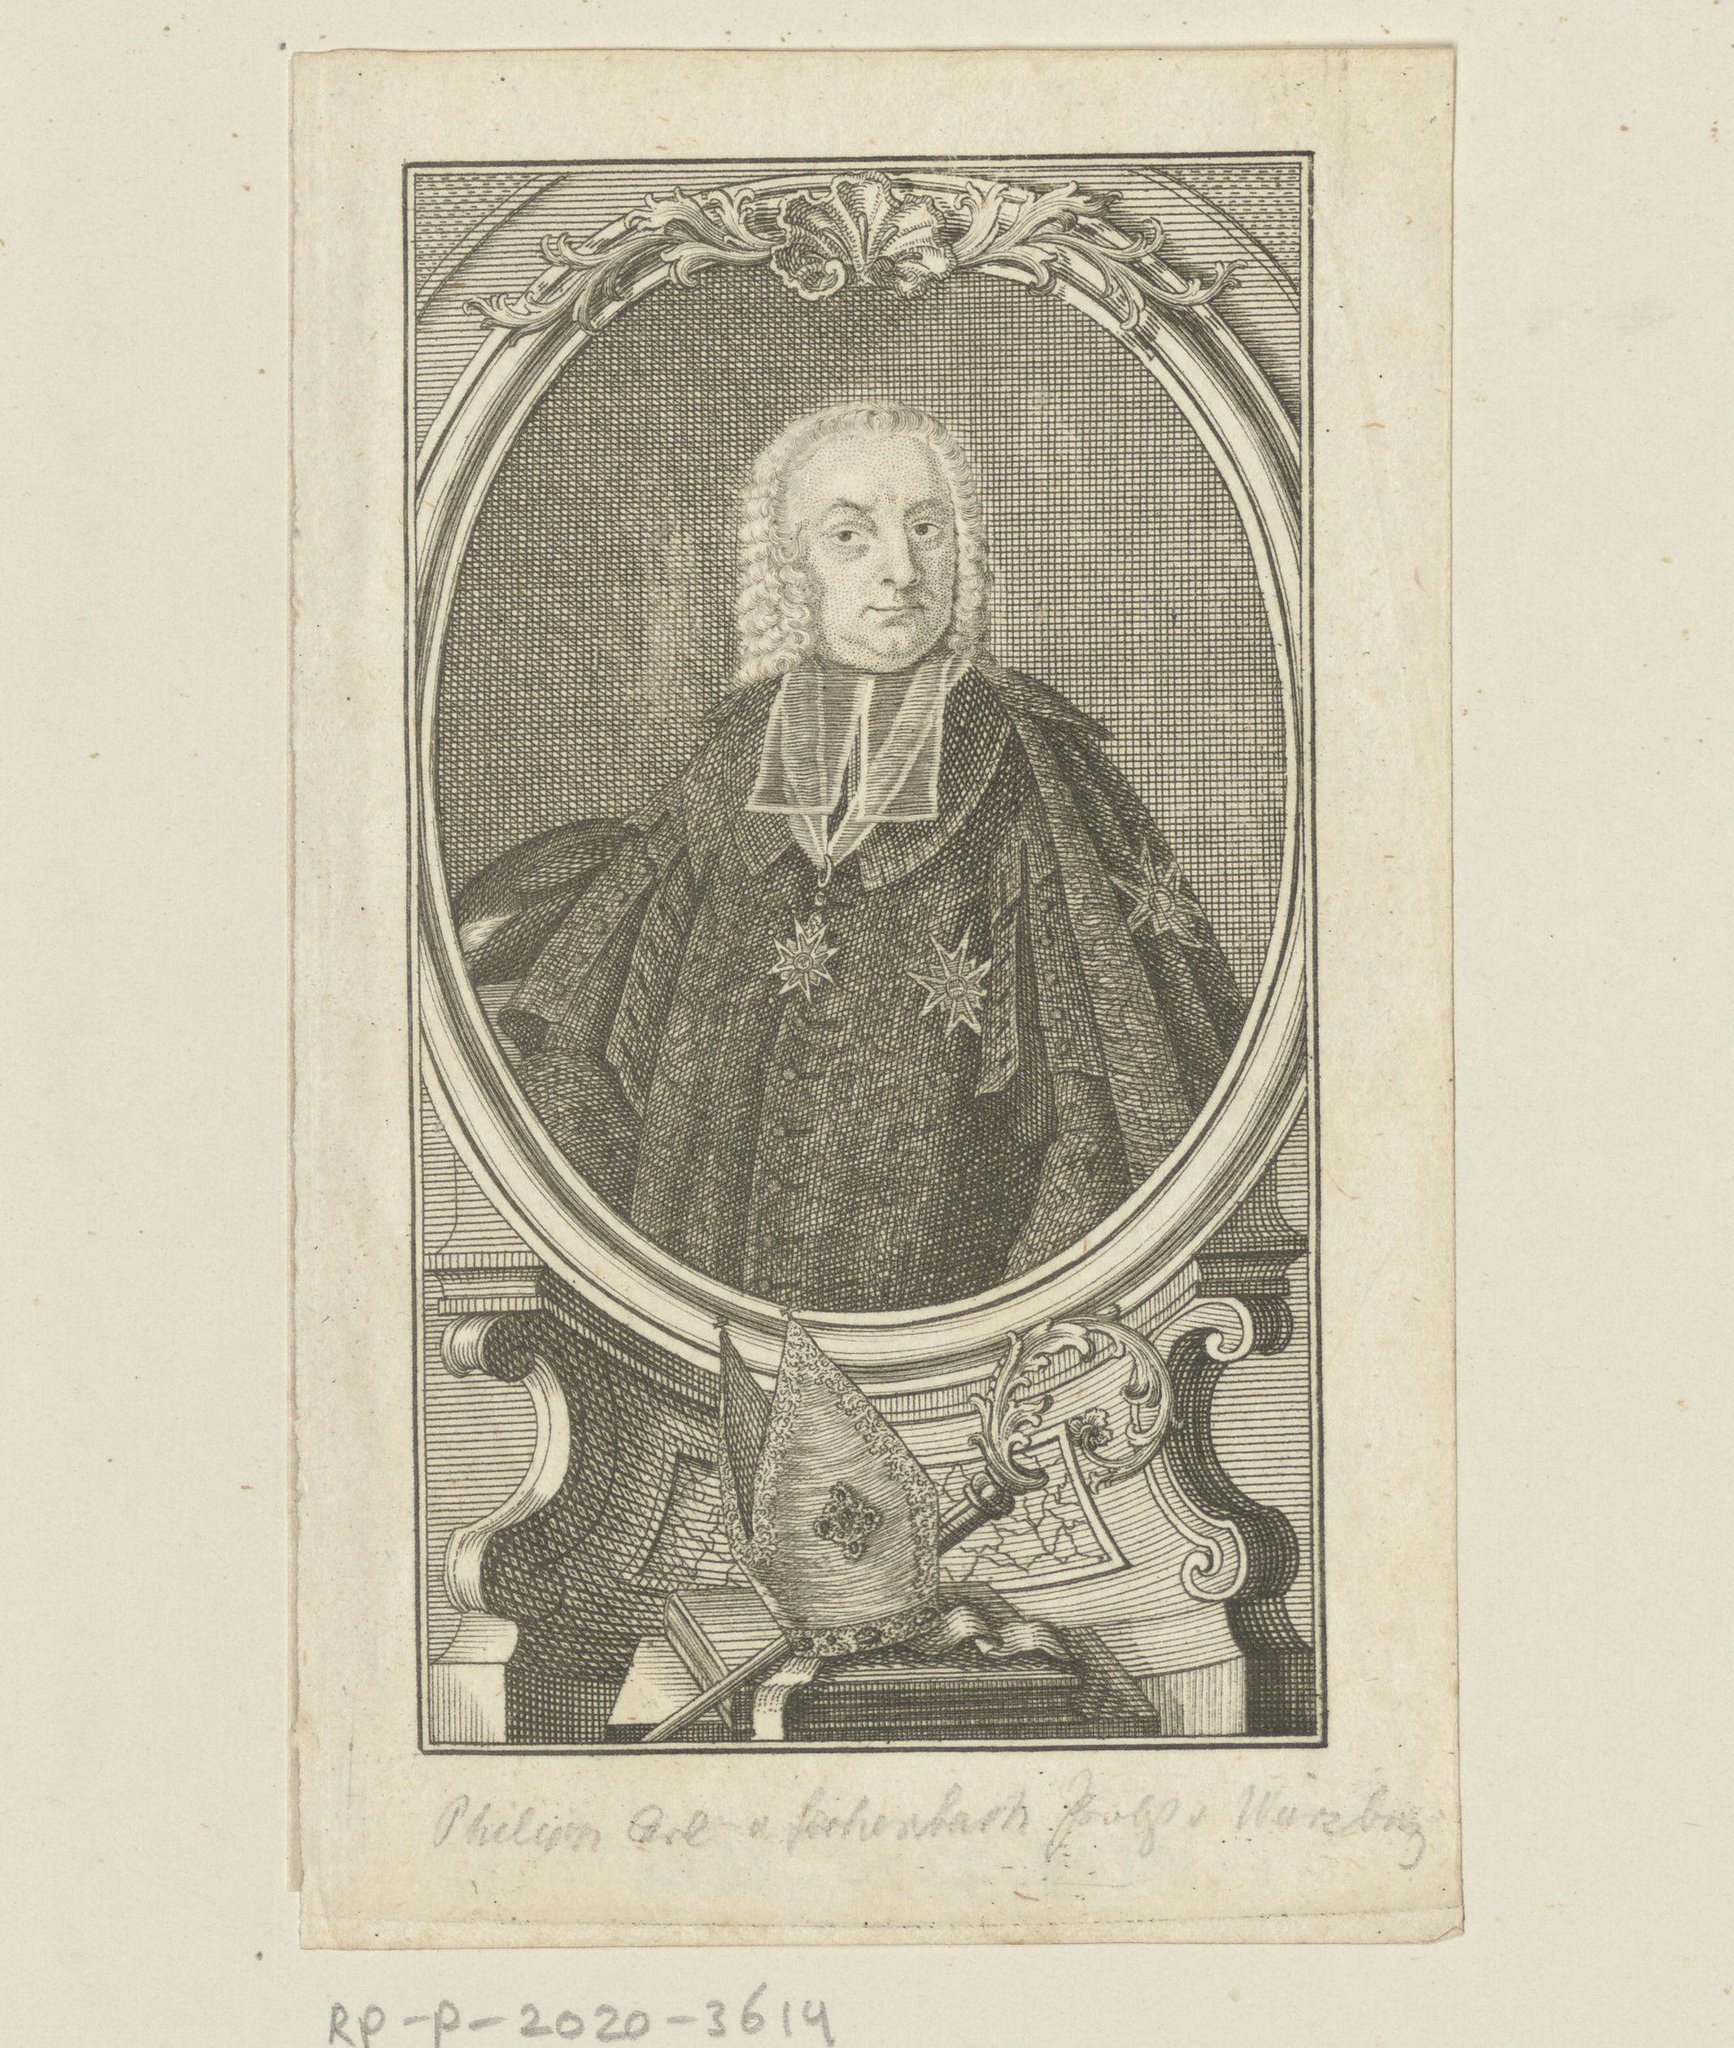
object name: print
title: Portret van een onbekende man, mogelijk Adam Friedrich von Seinsheim of Friedrich Karl von Schönborn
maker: Anonymous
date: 1680-1780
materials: paper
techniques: etching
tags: archbishop, bishop, etc. (roman catholic), anonymous historical person portrayed alone, insignia of bishop, e.g. mitre, crozier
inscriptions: inscription: ‘Philipp Carl v. Fechensbach [...] v. Wurzburg’